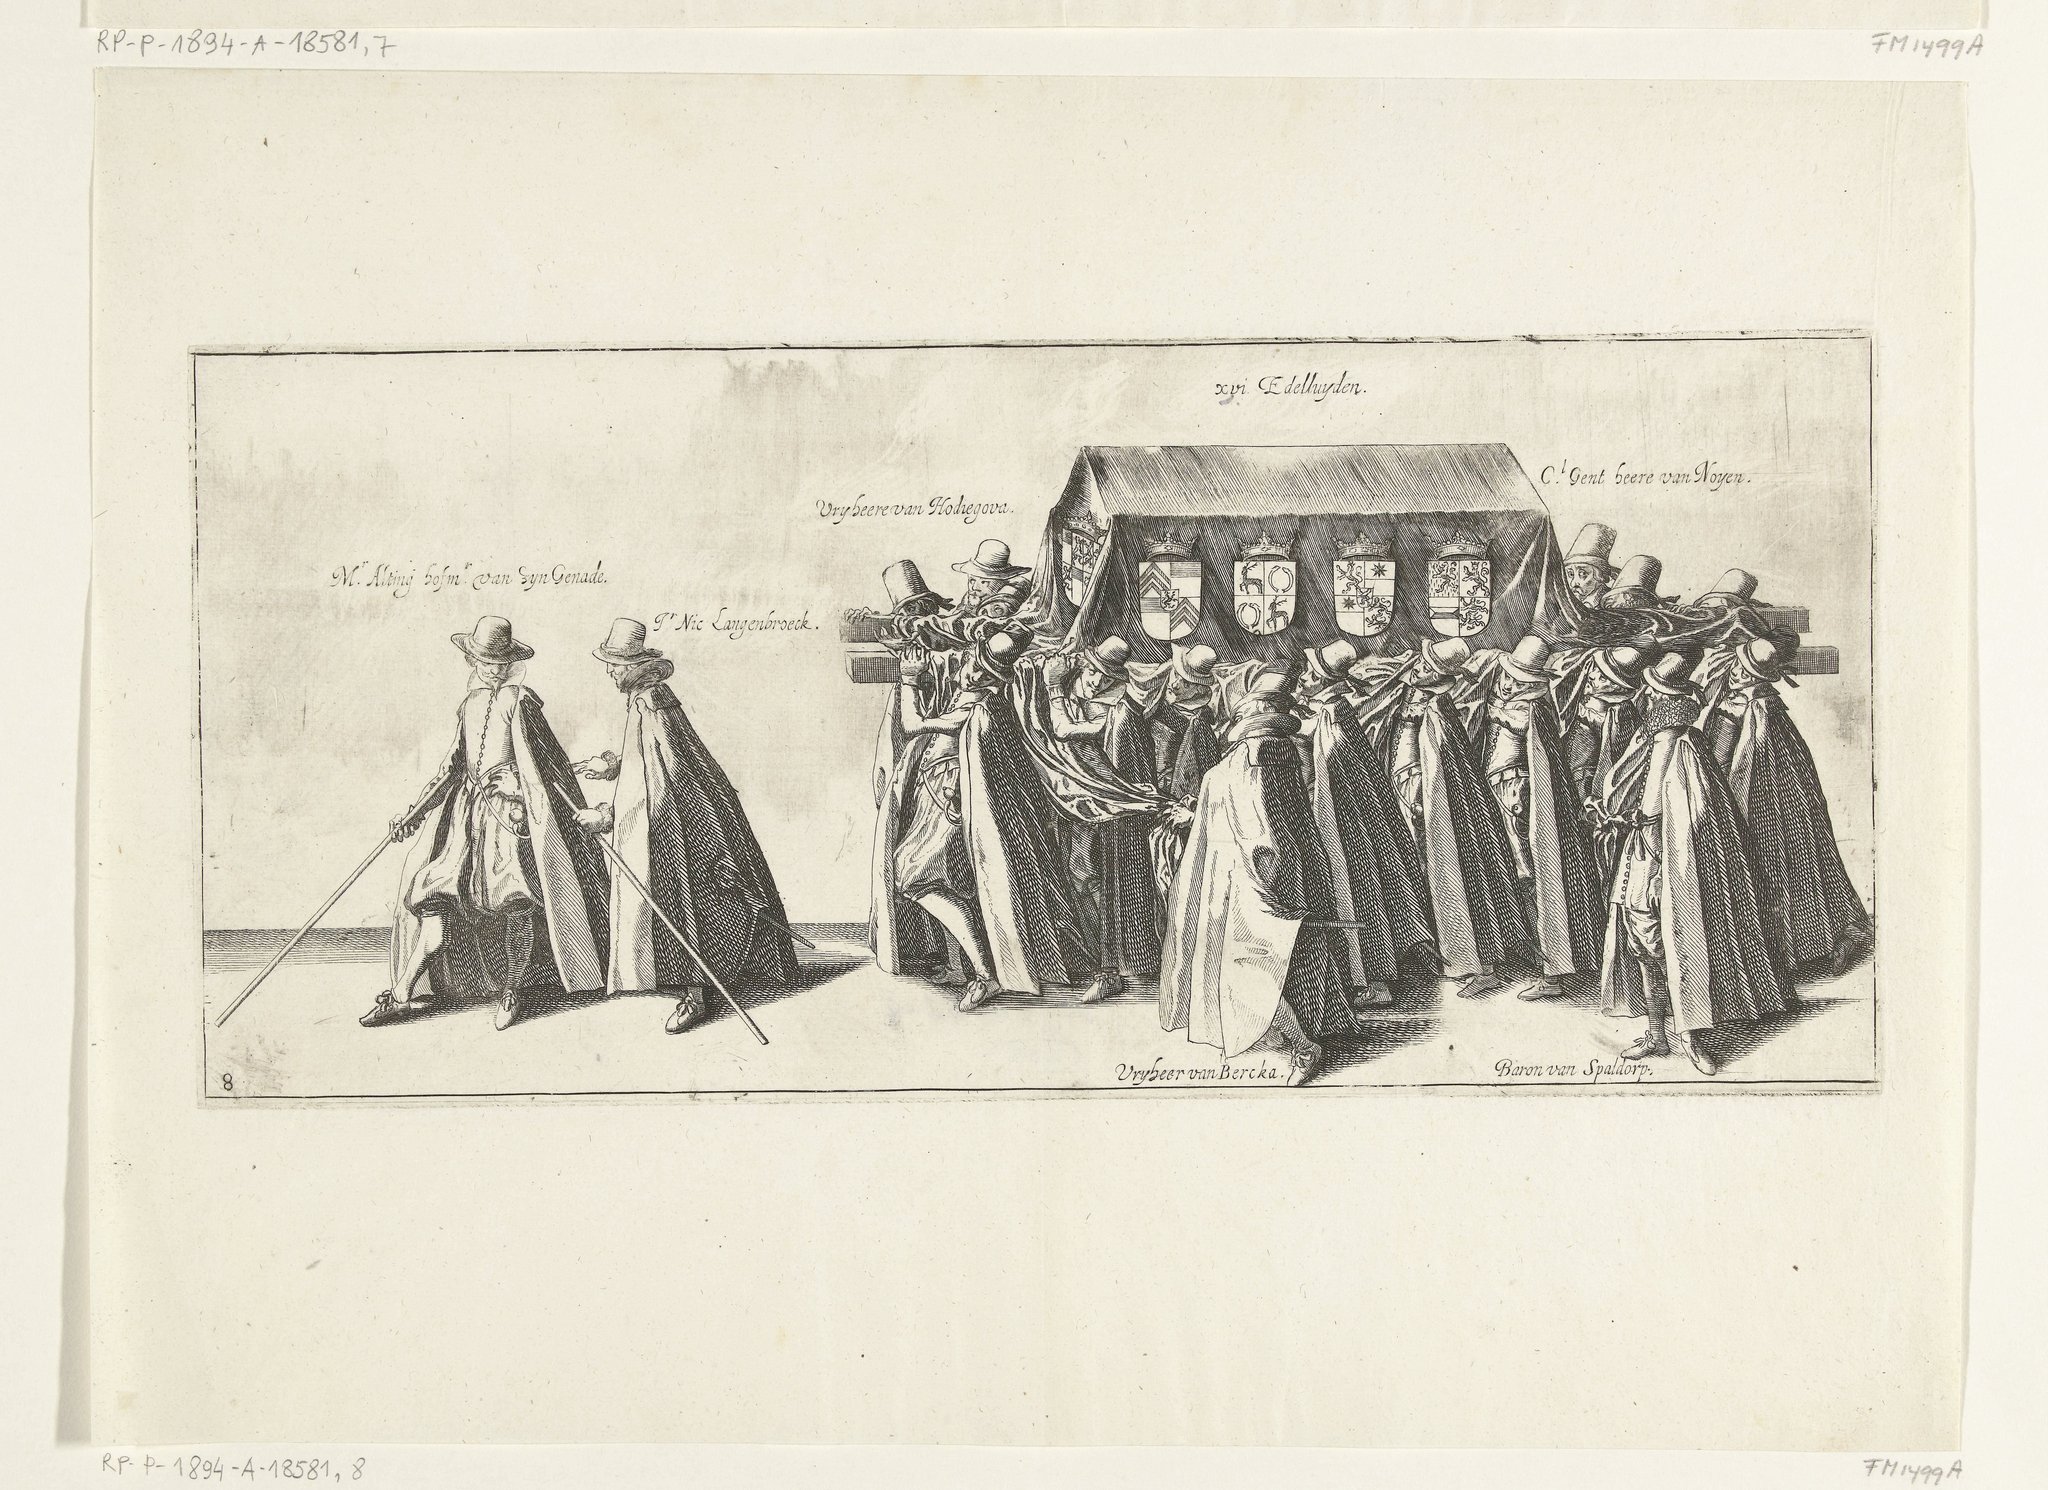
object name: print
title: Begrafenis van Johann Albrecht, graaf van Solms, 1623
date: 1615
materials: paper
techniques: etching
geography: northern netherlands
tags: the hague, cortege, funeral procession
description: De begrafenisstoet met de kist (plaat 8). De lijkkist gedragen door jonge edelen. Onderdeel van de serie prenten van de begrafenisoptocht van Johann Albrecht, graaf van Solms, op 25 mei 1623 te Den Haag.